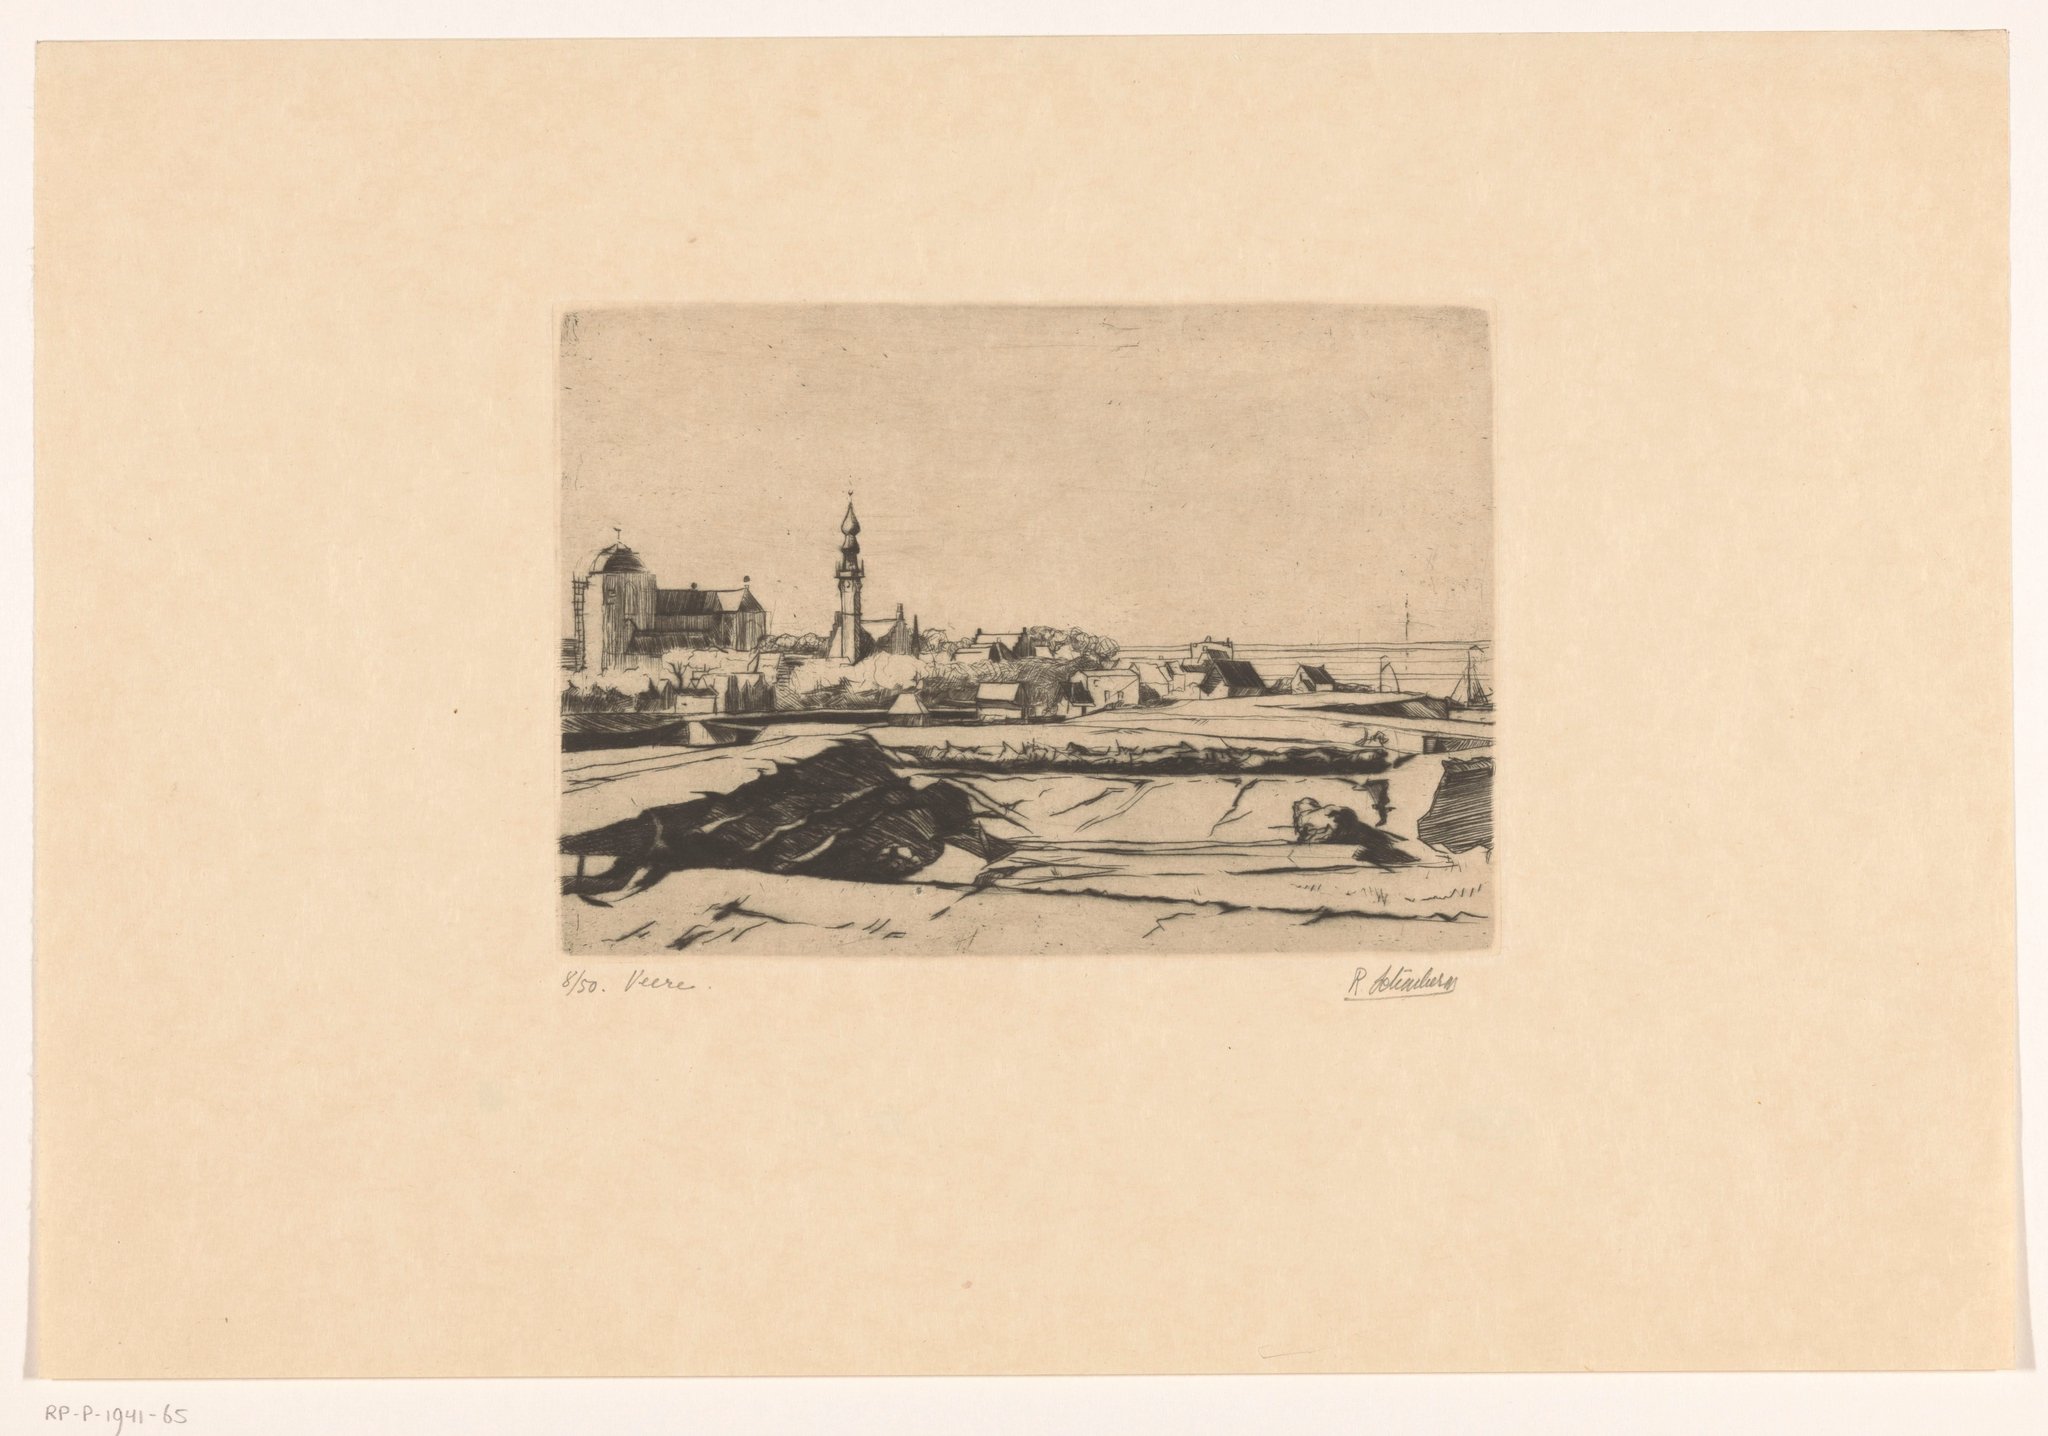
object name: print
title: Veere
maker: rudolf schönberg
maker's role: print maker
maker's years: 1901-1944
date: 1911-1941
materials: paper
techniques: drypoint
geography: netherlands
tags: city-view in general; 'veduta'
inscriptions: collector's mark: Lugt 2228, collector's mark: Lugt 2760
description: Gezicht op Veere met links de toren van het stadhuis en de Grote Kerk.